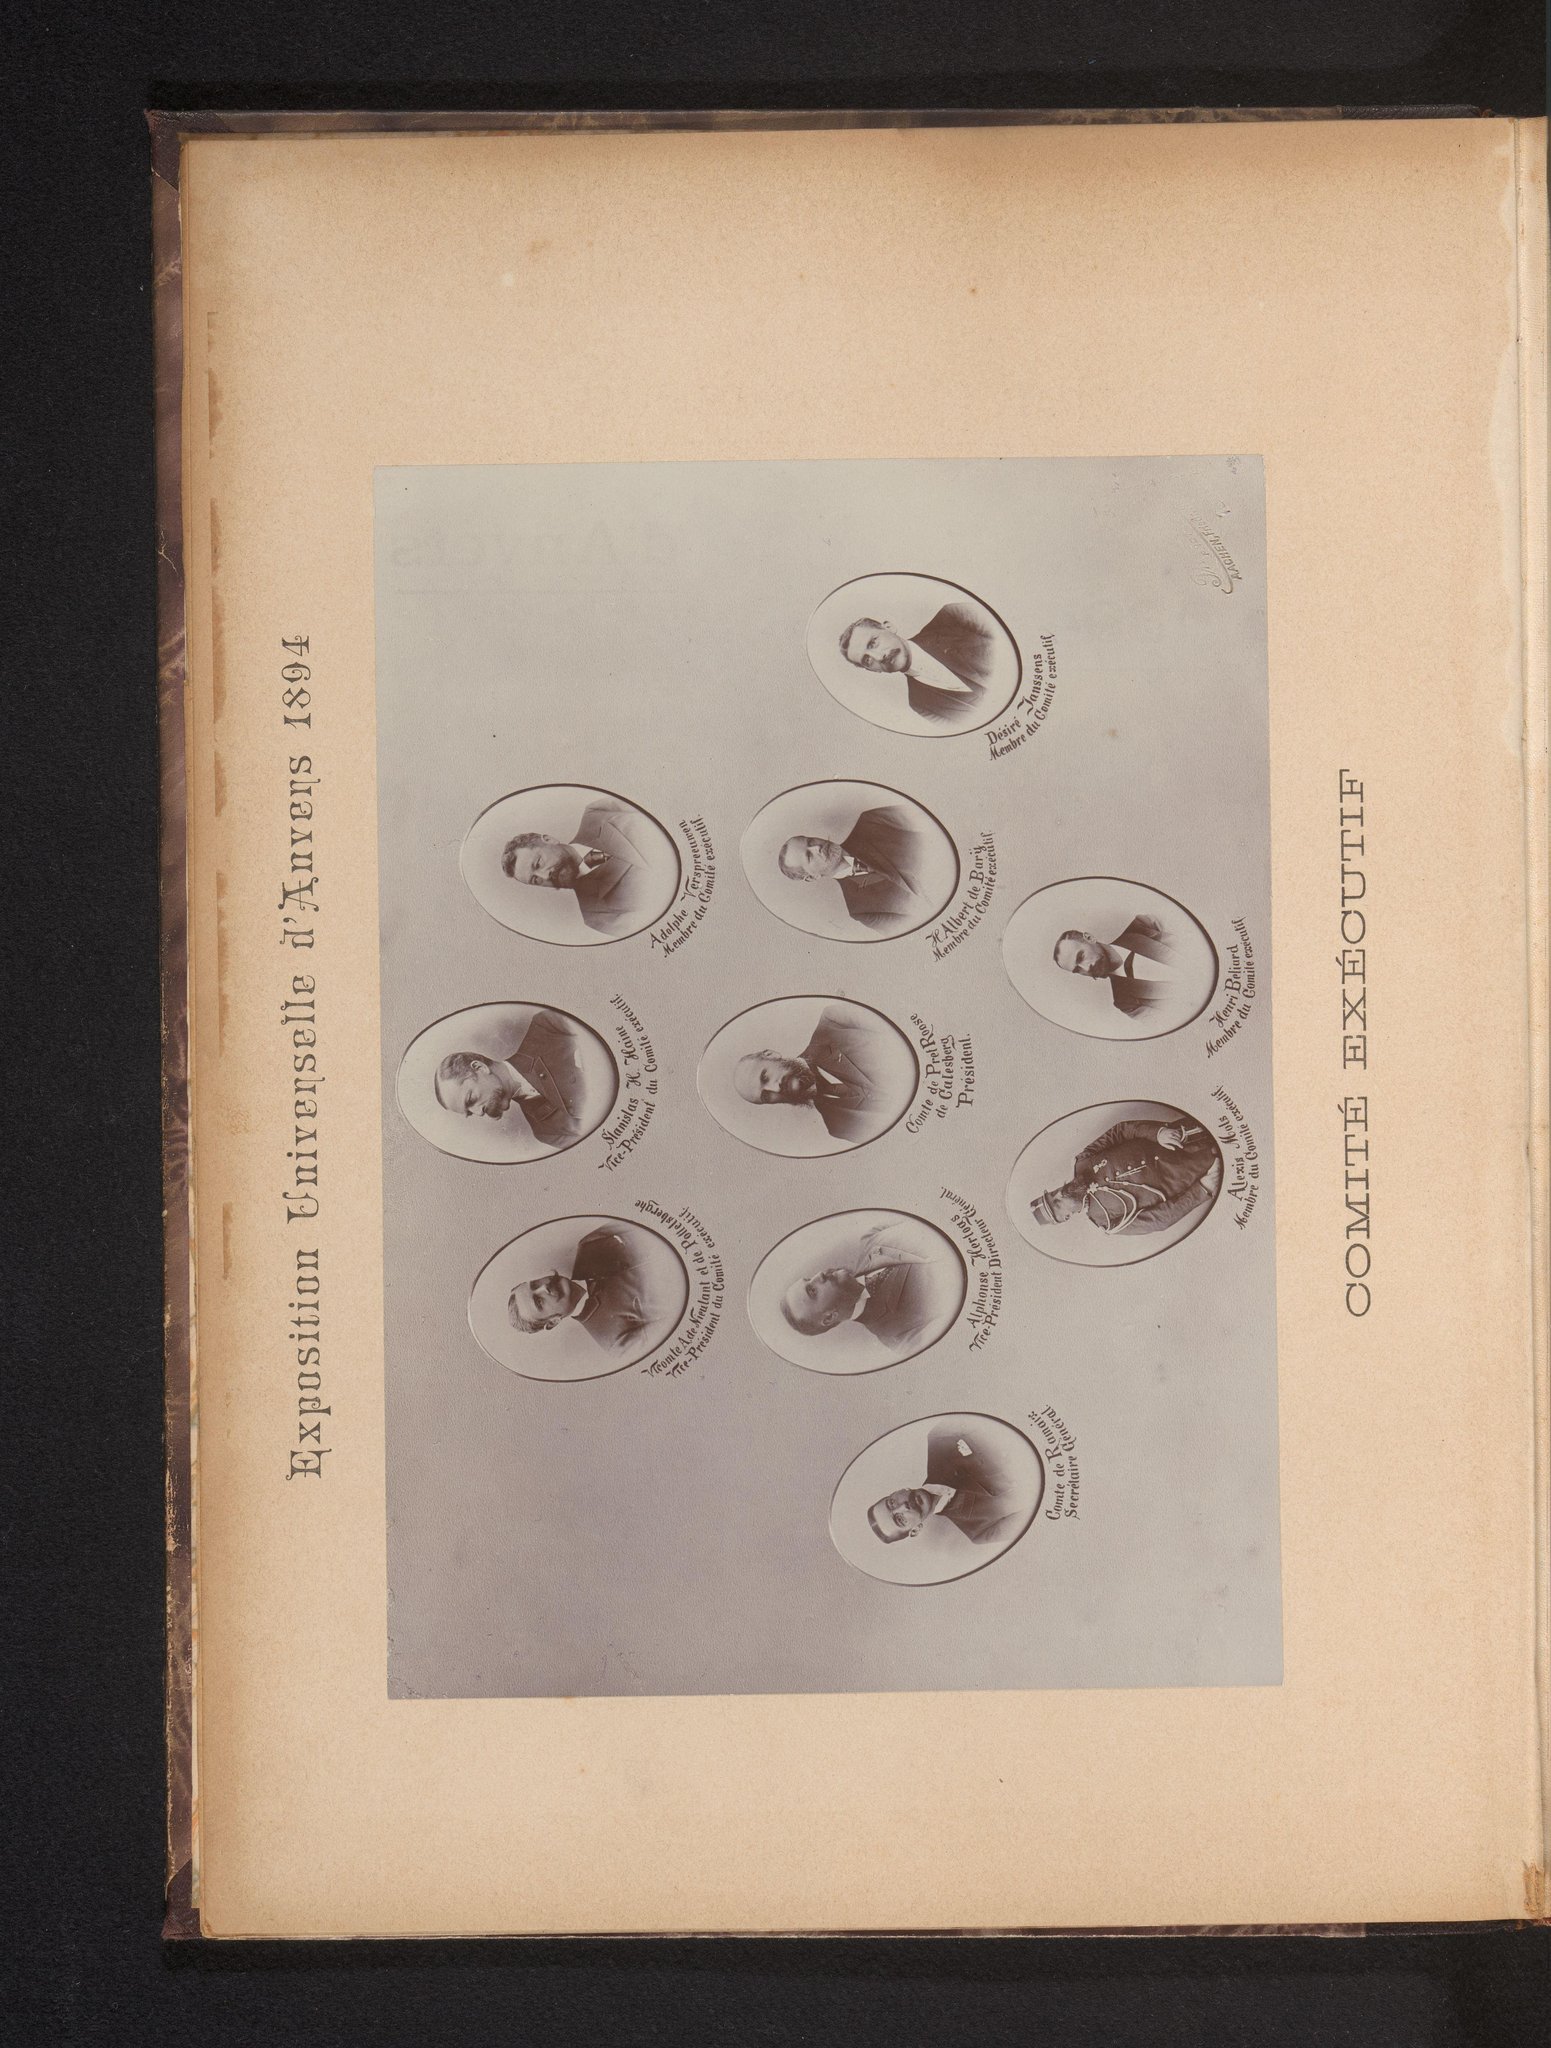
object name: page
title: Tien portretten in medaillon-vorm van de uitvoerende commissie van de Wereldtentoonstelling van Antwerpen in 1894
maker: th. lantin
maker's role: fotograaf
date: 1896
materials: photographic support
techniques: gelatin silver print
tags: historical persons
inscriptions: name: ‘Adolphe Verspreeuwen/ Membre du Comité exécutif.’, name: ‘Comte de Pret Roose/ de Calesberg/ Président.’, name: ‘Stanislas H. Hain/ Vice-President du Comité exécutif.’, name: ‘Henri Beliard/ Membre du Comité exécutif.’, name: ‘Alphonse Hertogs/ Vice-President Directeur Général.’, name: ‘H. Albert de Barij/ Membre du Comité exécutif.’, name: ‘Désiré Janssens/ Membre du Comité exécutif.’, name: ‘Vicomte A. de Nieutant et de Pottelsberghe/ Vice-President du Comité exécutif.’, check stamp: ‘Th. Lantin/ Photograph/ AACHEN, Friedn. Wilhelm[..]/ 1896.’, name: ‘Alexis Mols/ Membre du Comité exécutif.’, name: ‘Comte de Ramaix/ Secrétaire Général.’